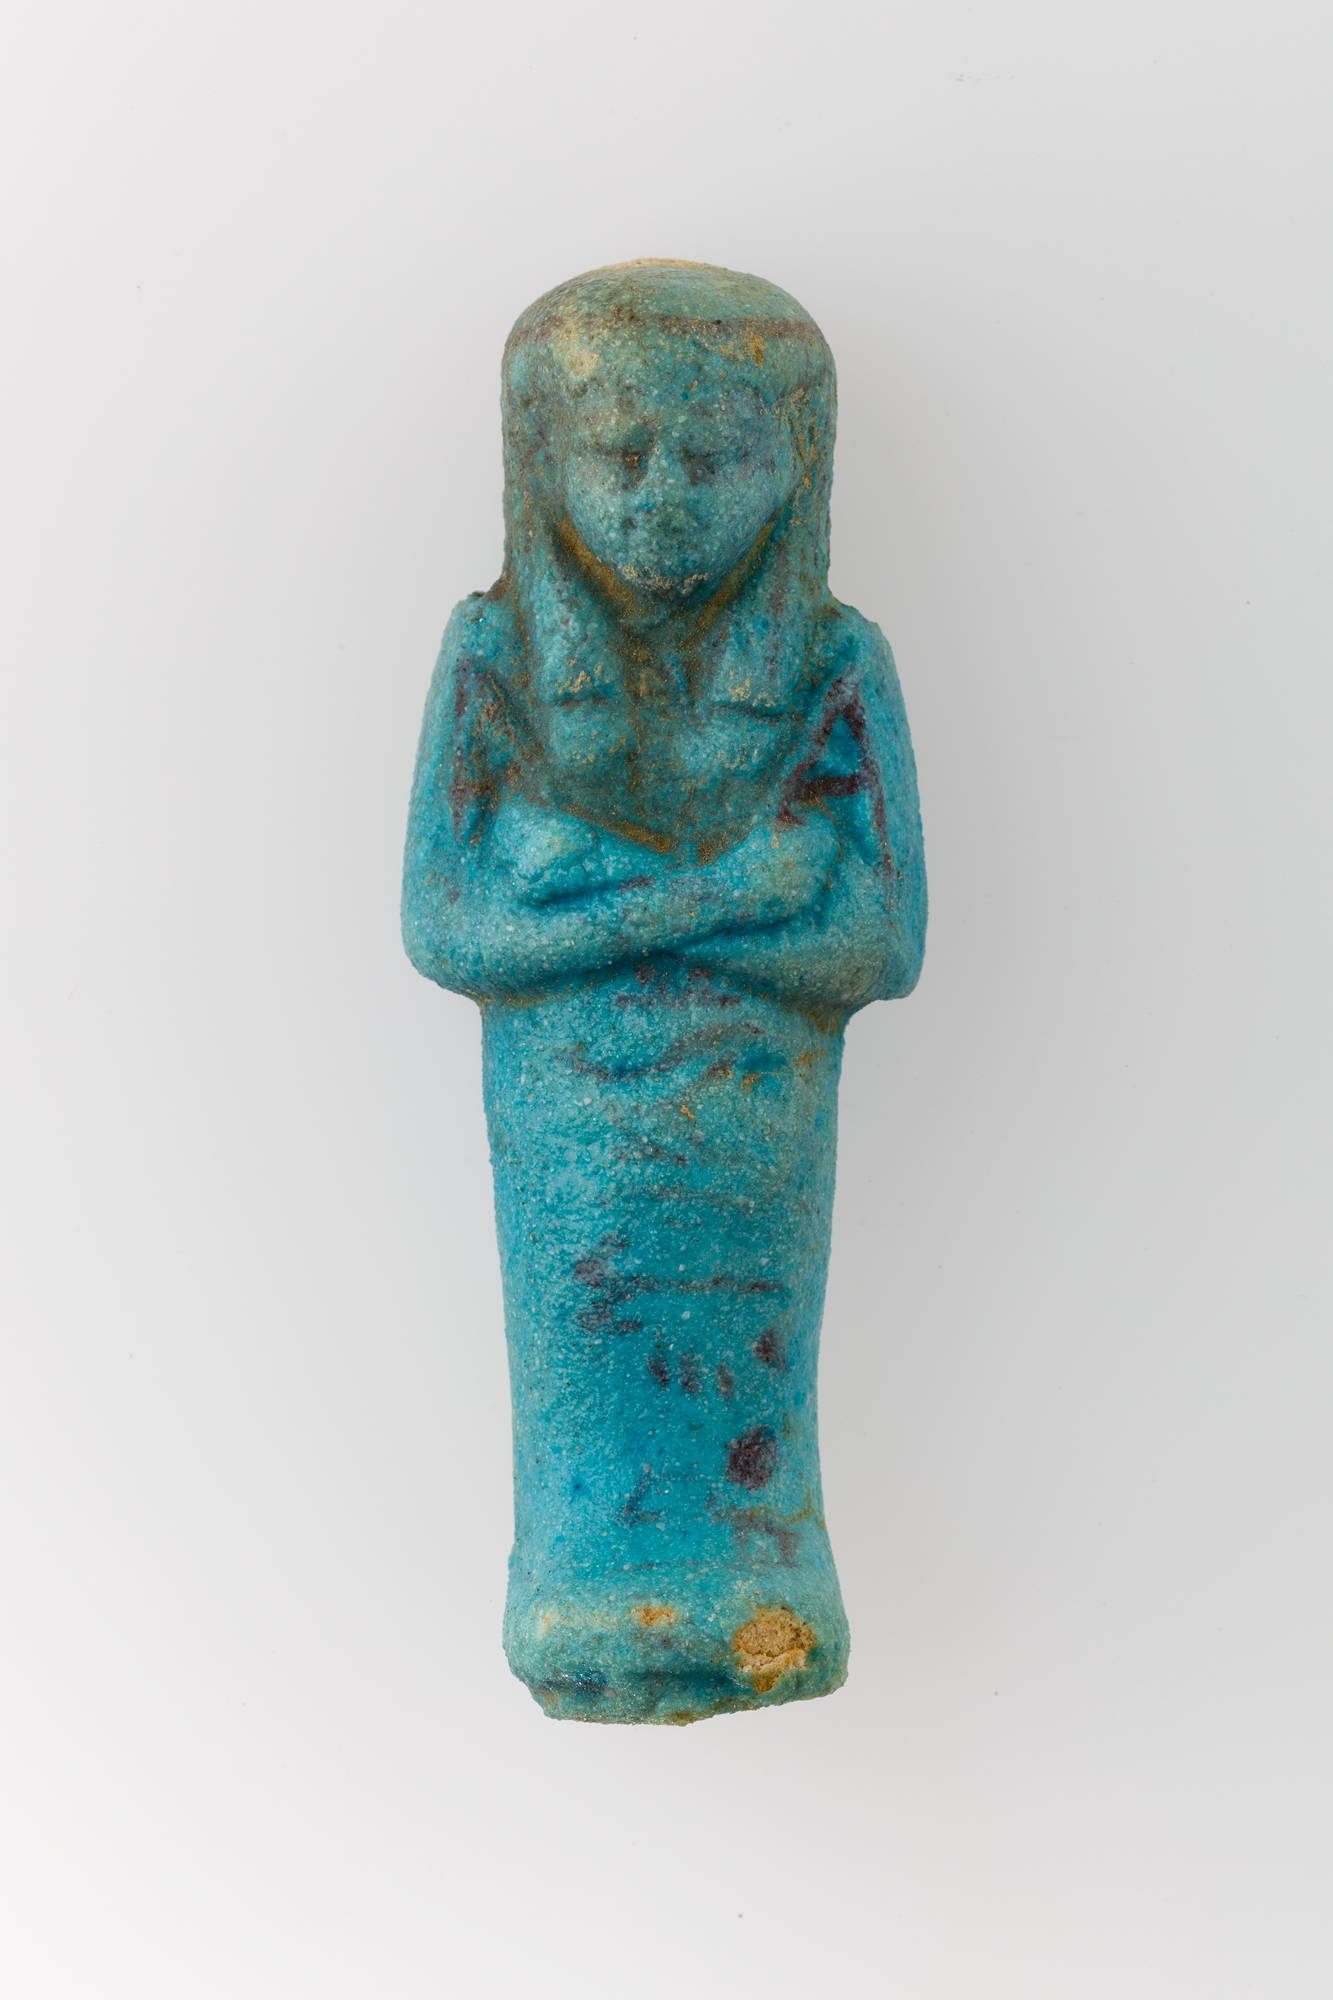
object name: shabti, henettawy c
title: Worker Shabti of Henettawy (C), Daughter of Isetemkheb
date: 990-970 BCE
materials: faience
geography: egypt